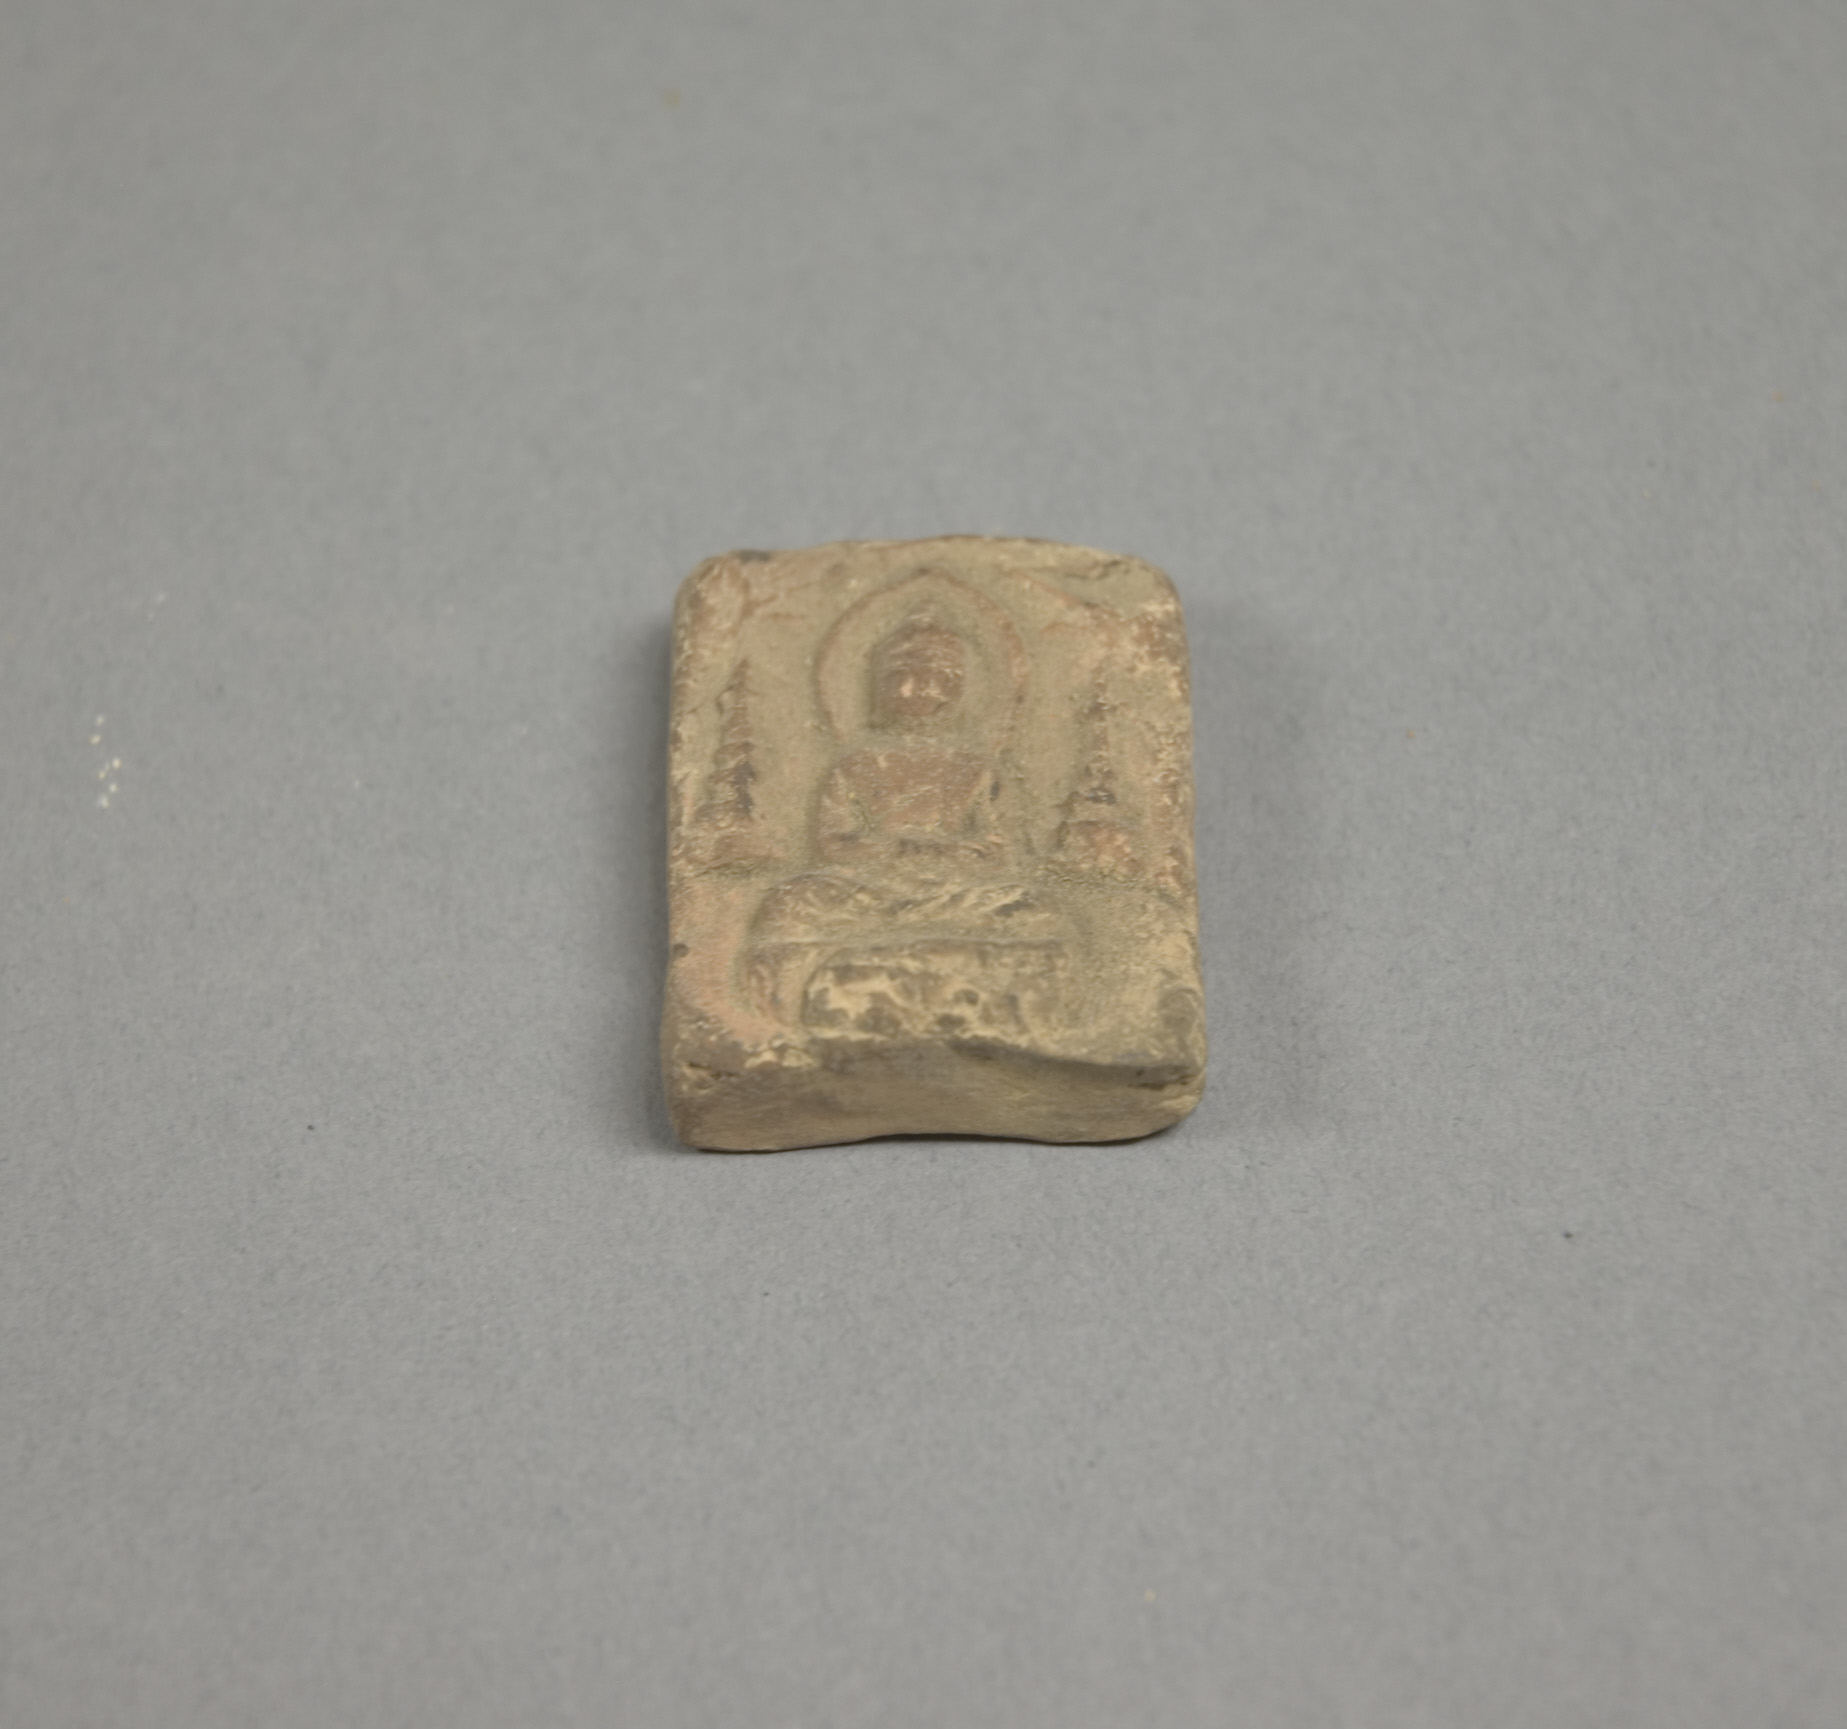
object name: votive tablet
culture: chinese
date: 618-907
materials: terracotta